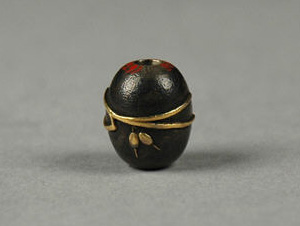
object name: ojime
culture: japanese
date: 1801-1900